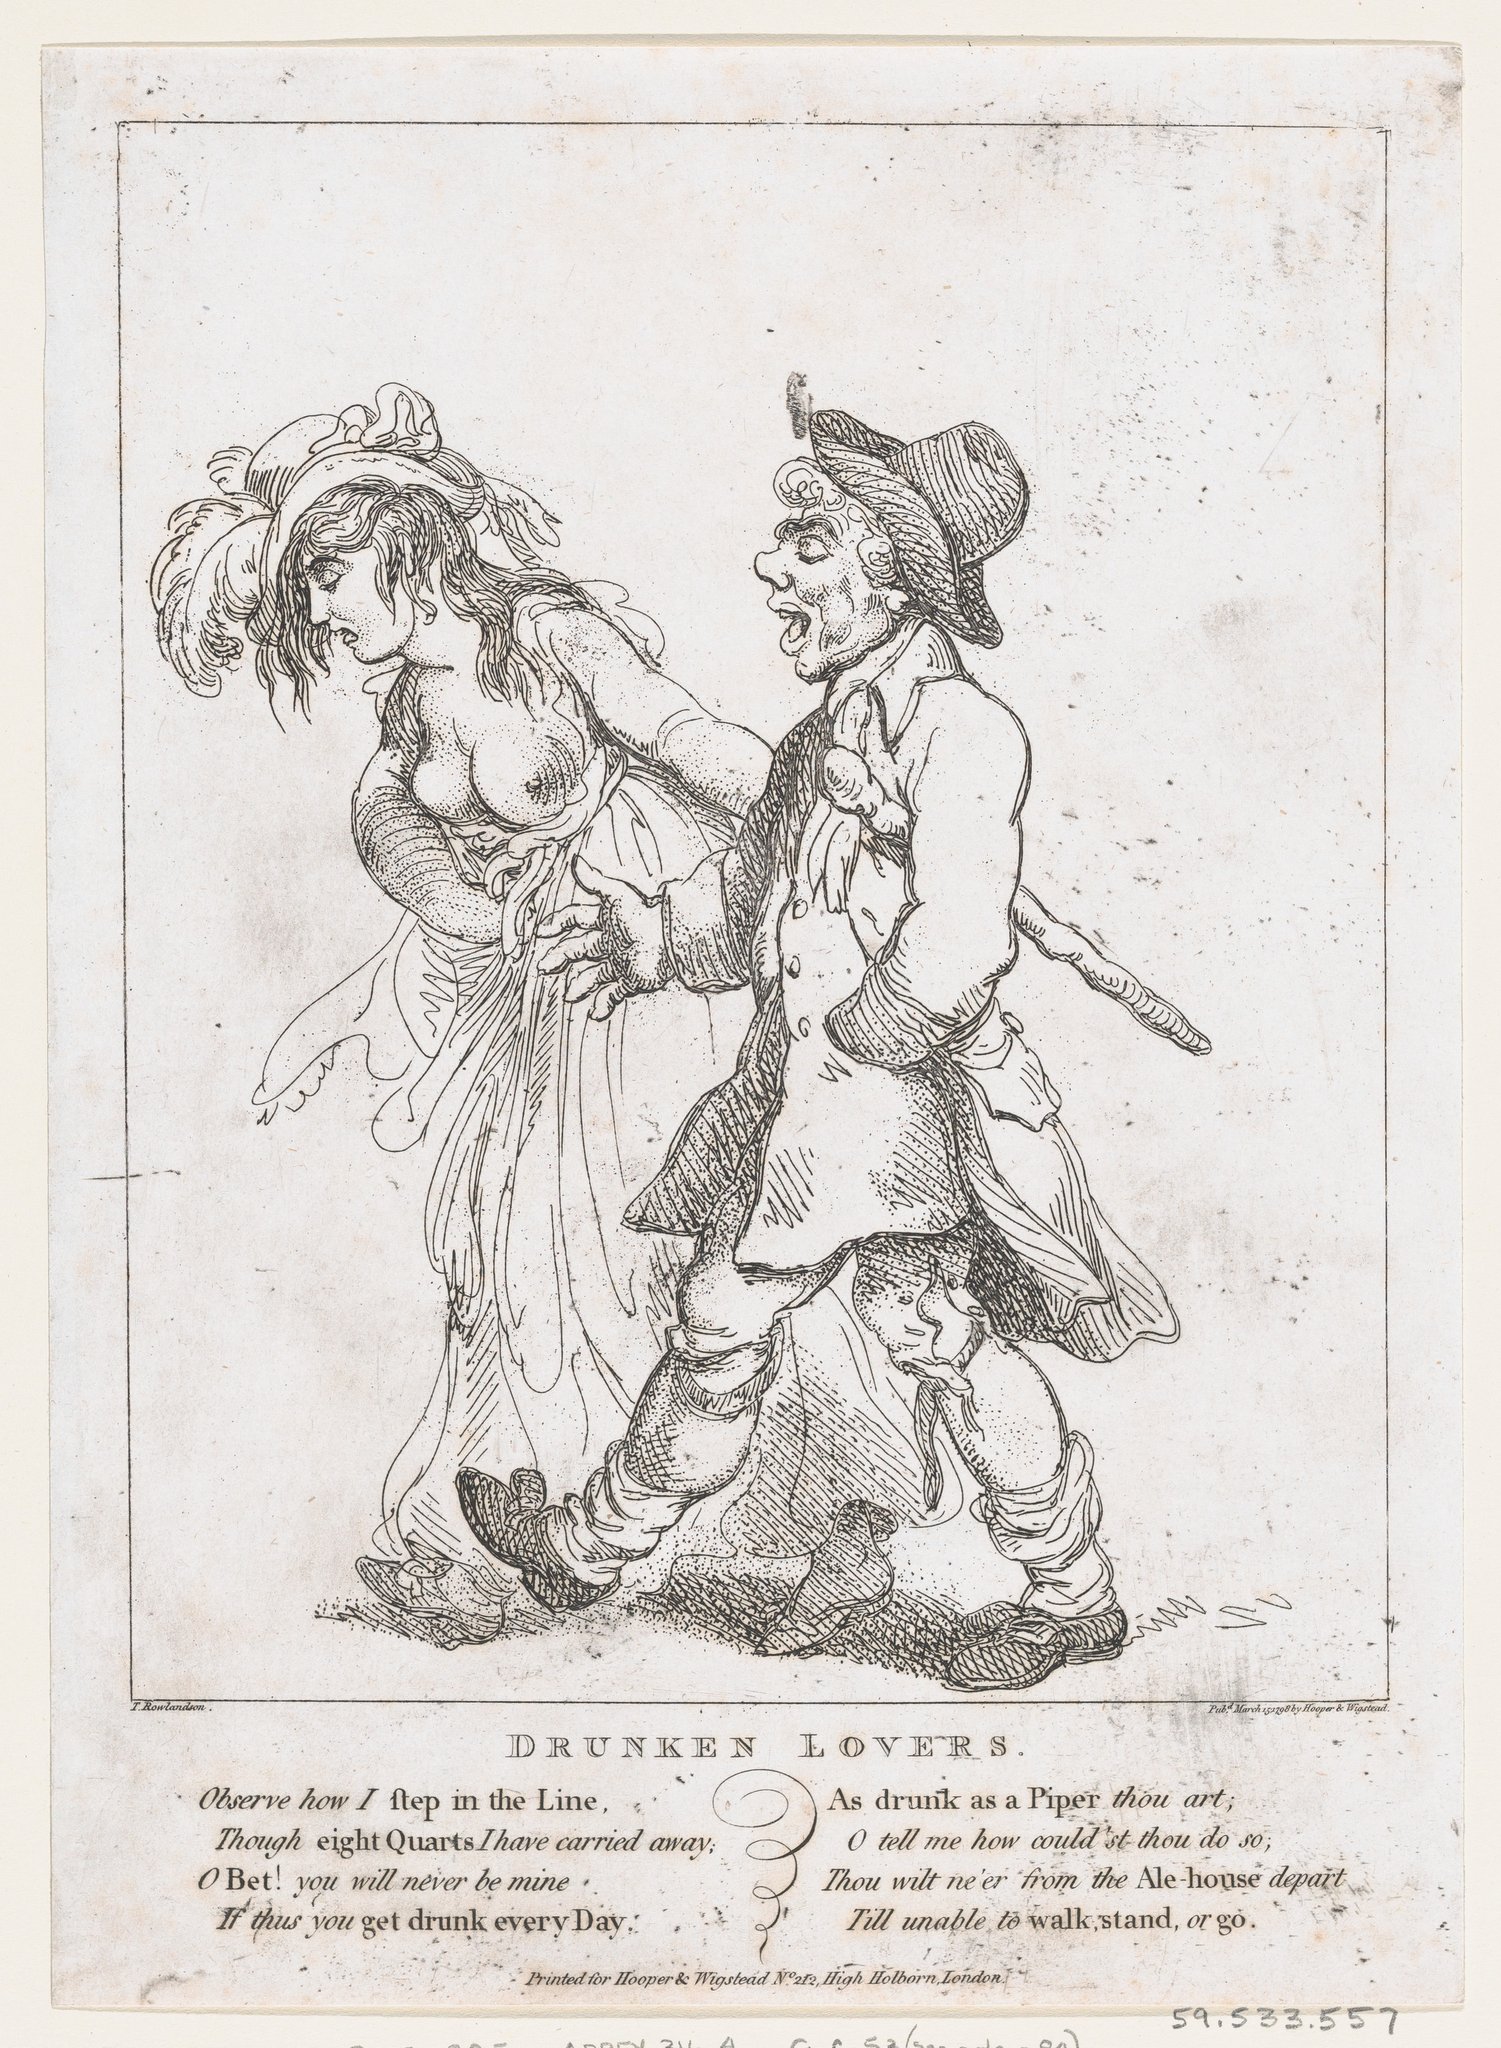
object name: print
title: Drunken Lovers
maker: thomas rowlandson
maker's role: artist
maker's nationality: british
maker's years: 1757-1827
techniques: etching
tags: satire,drunkenness,couples,men,lovers,female nudes